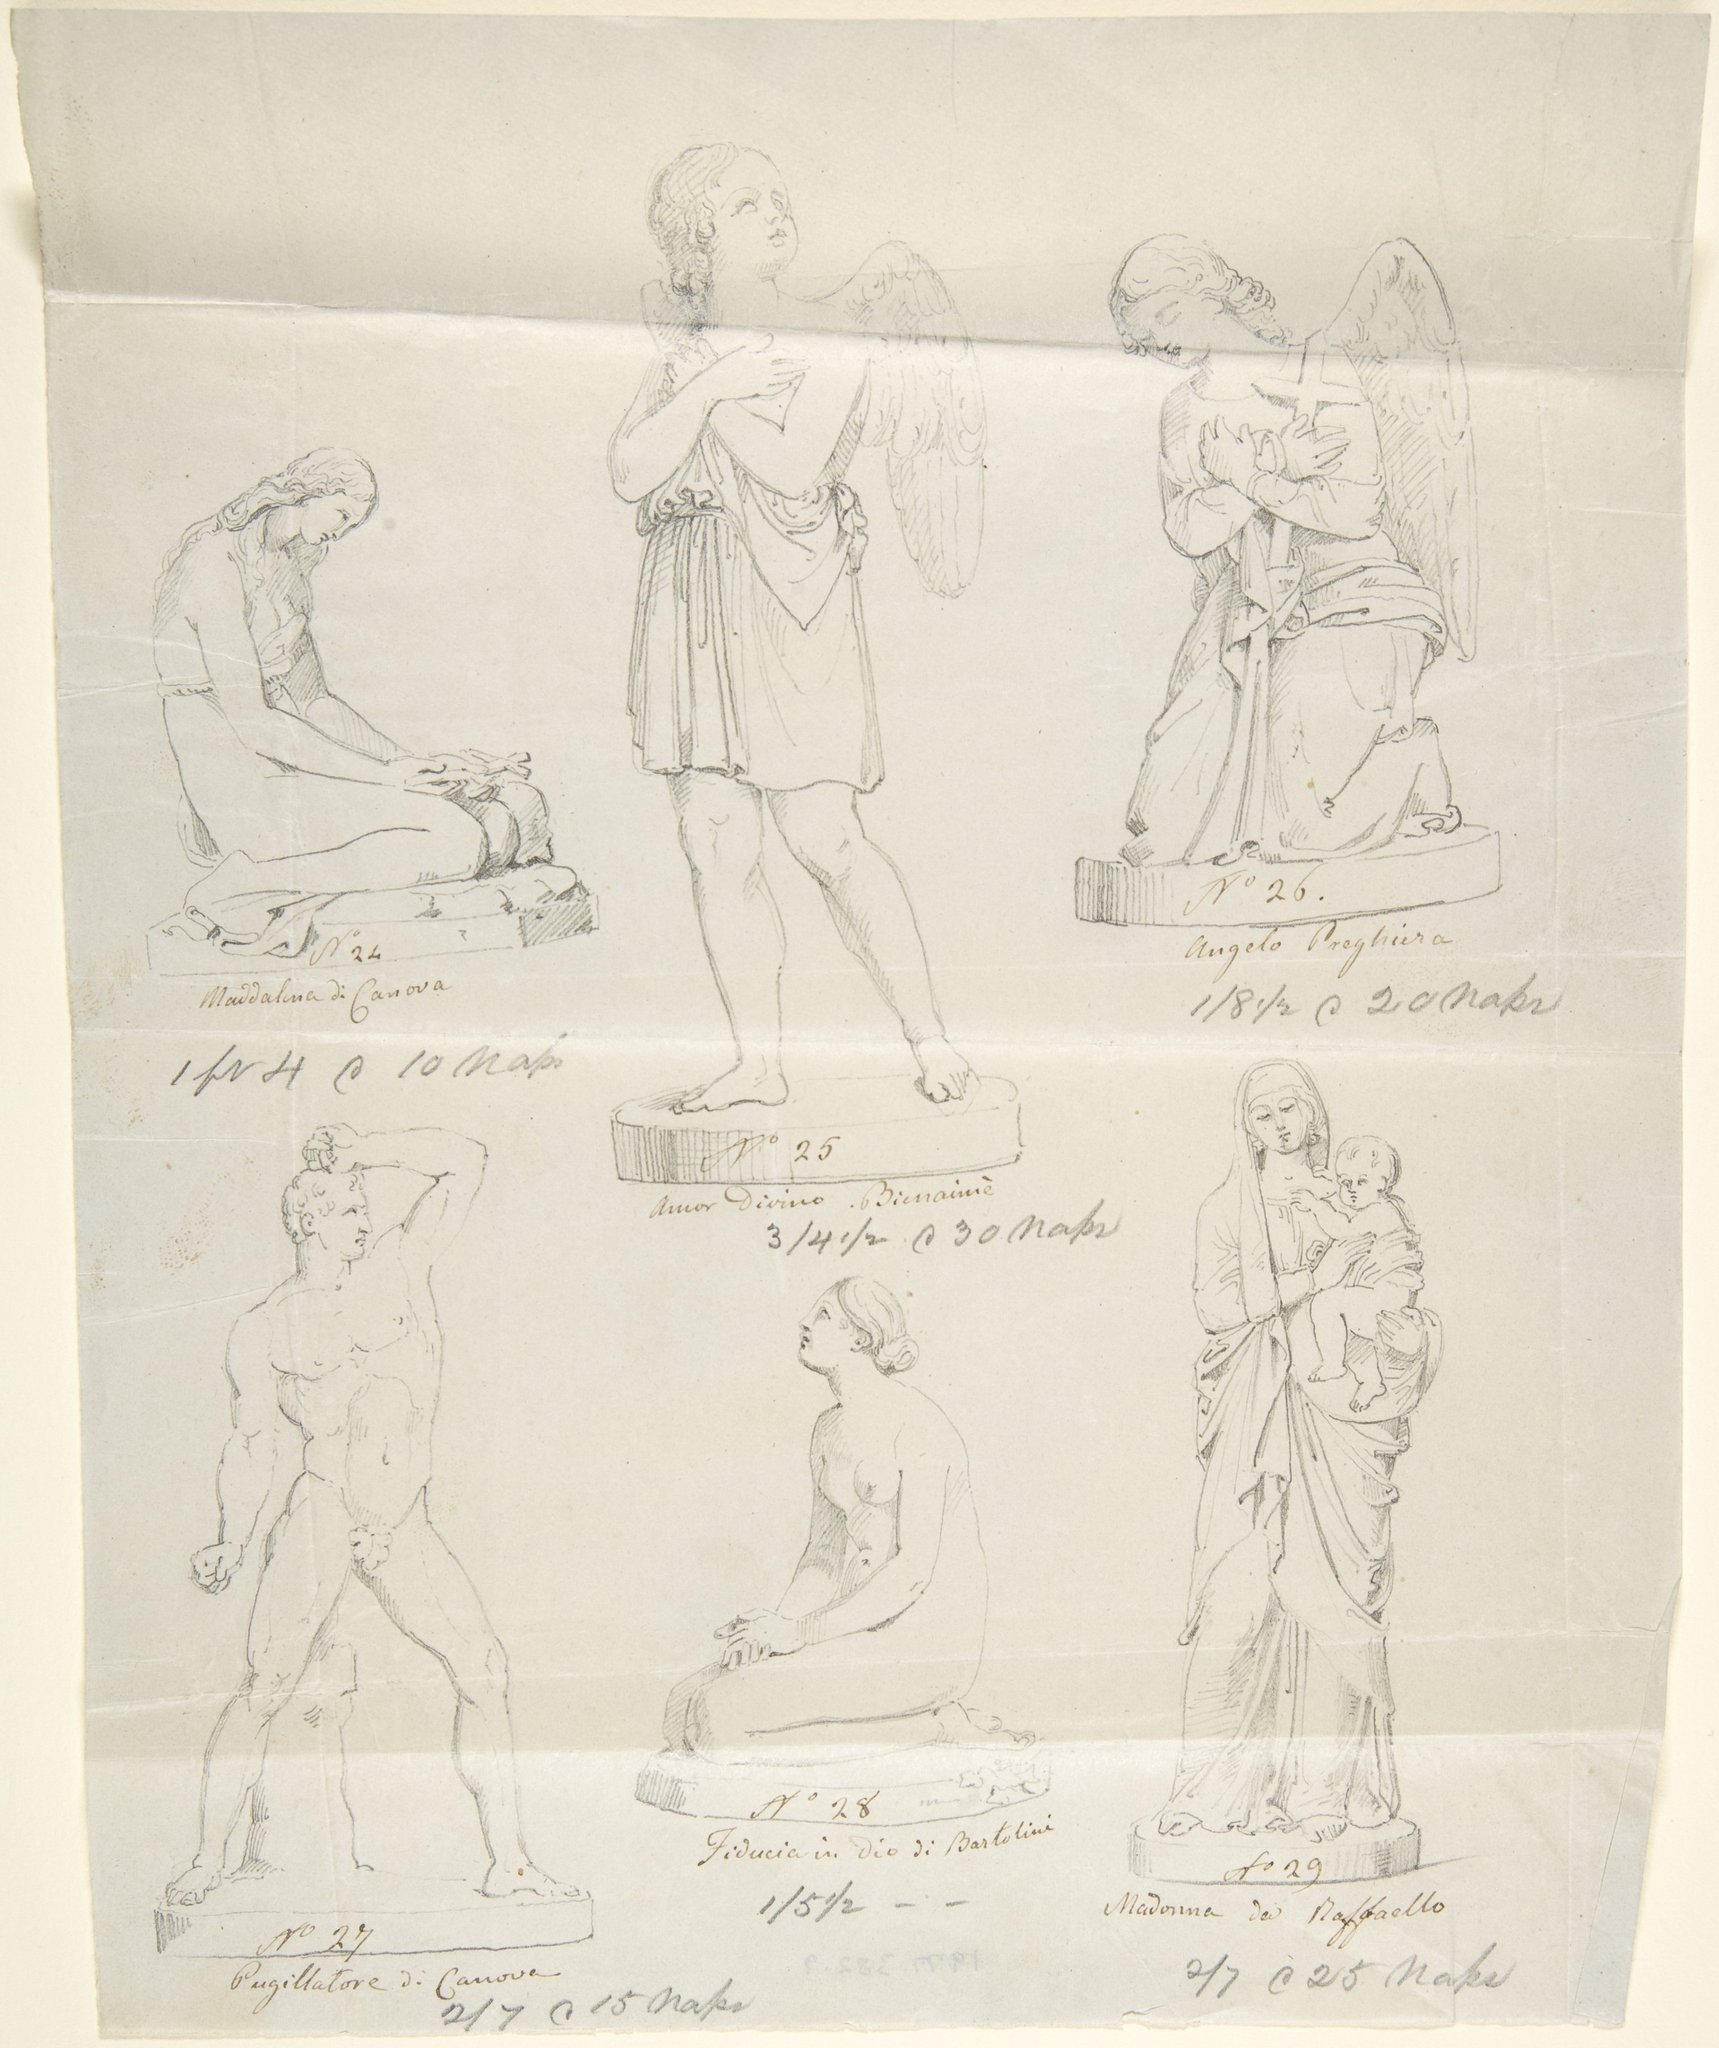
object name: drawing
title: Sketches of six statues: Magdalen by Canova, Divine Love by Bienaimé, Praying Angel, Boxer by Canova, Trust in God by Bartolini, and Madonna by Raphael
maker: john gibson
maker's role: artist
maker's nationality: british, born wales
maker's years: 1790-1866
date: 1850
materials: graphite, ink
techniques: pen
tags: male nudes,female nudes,angels,madonna and child,cross